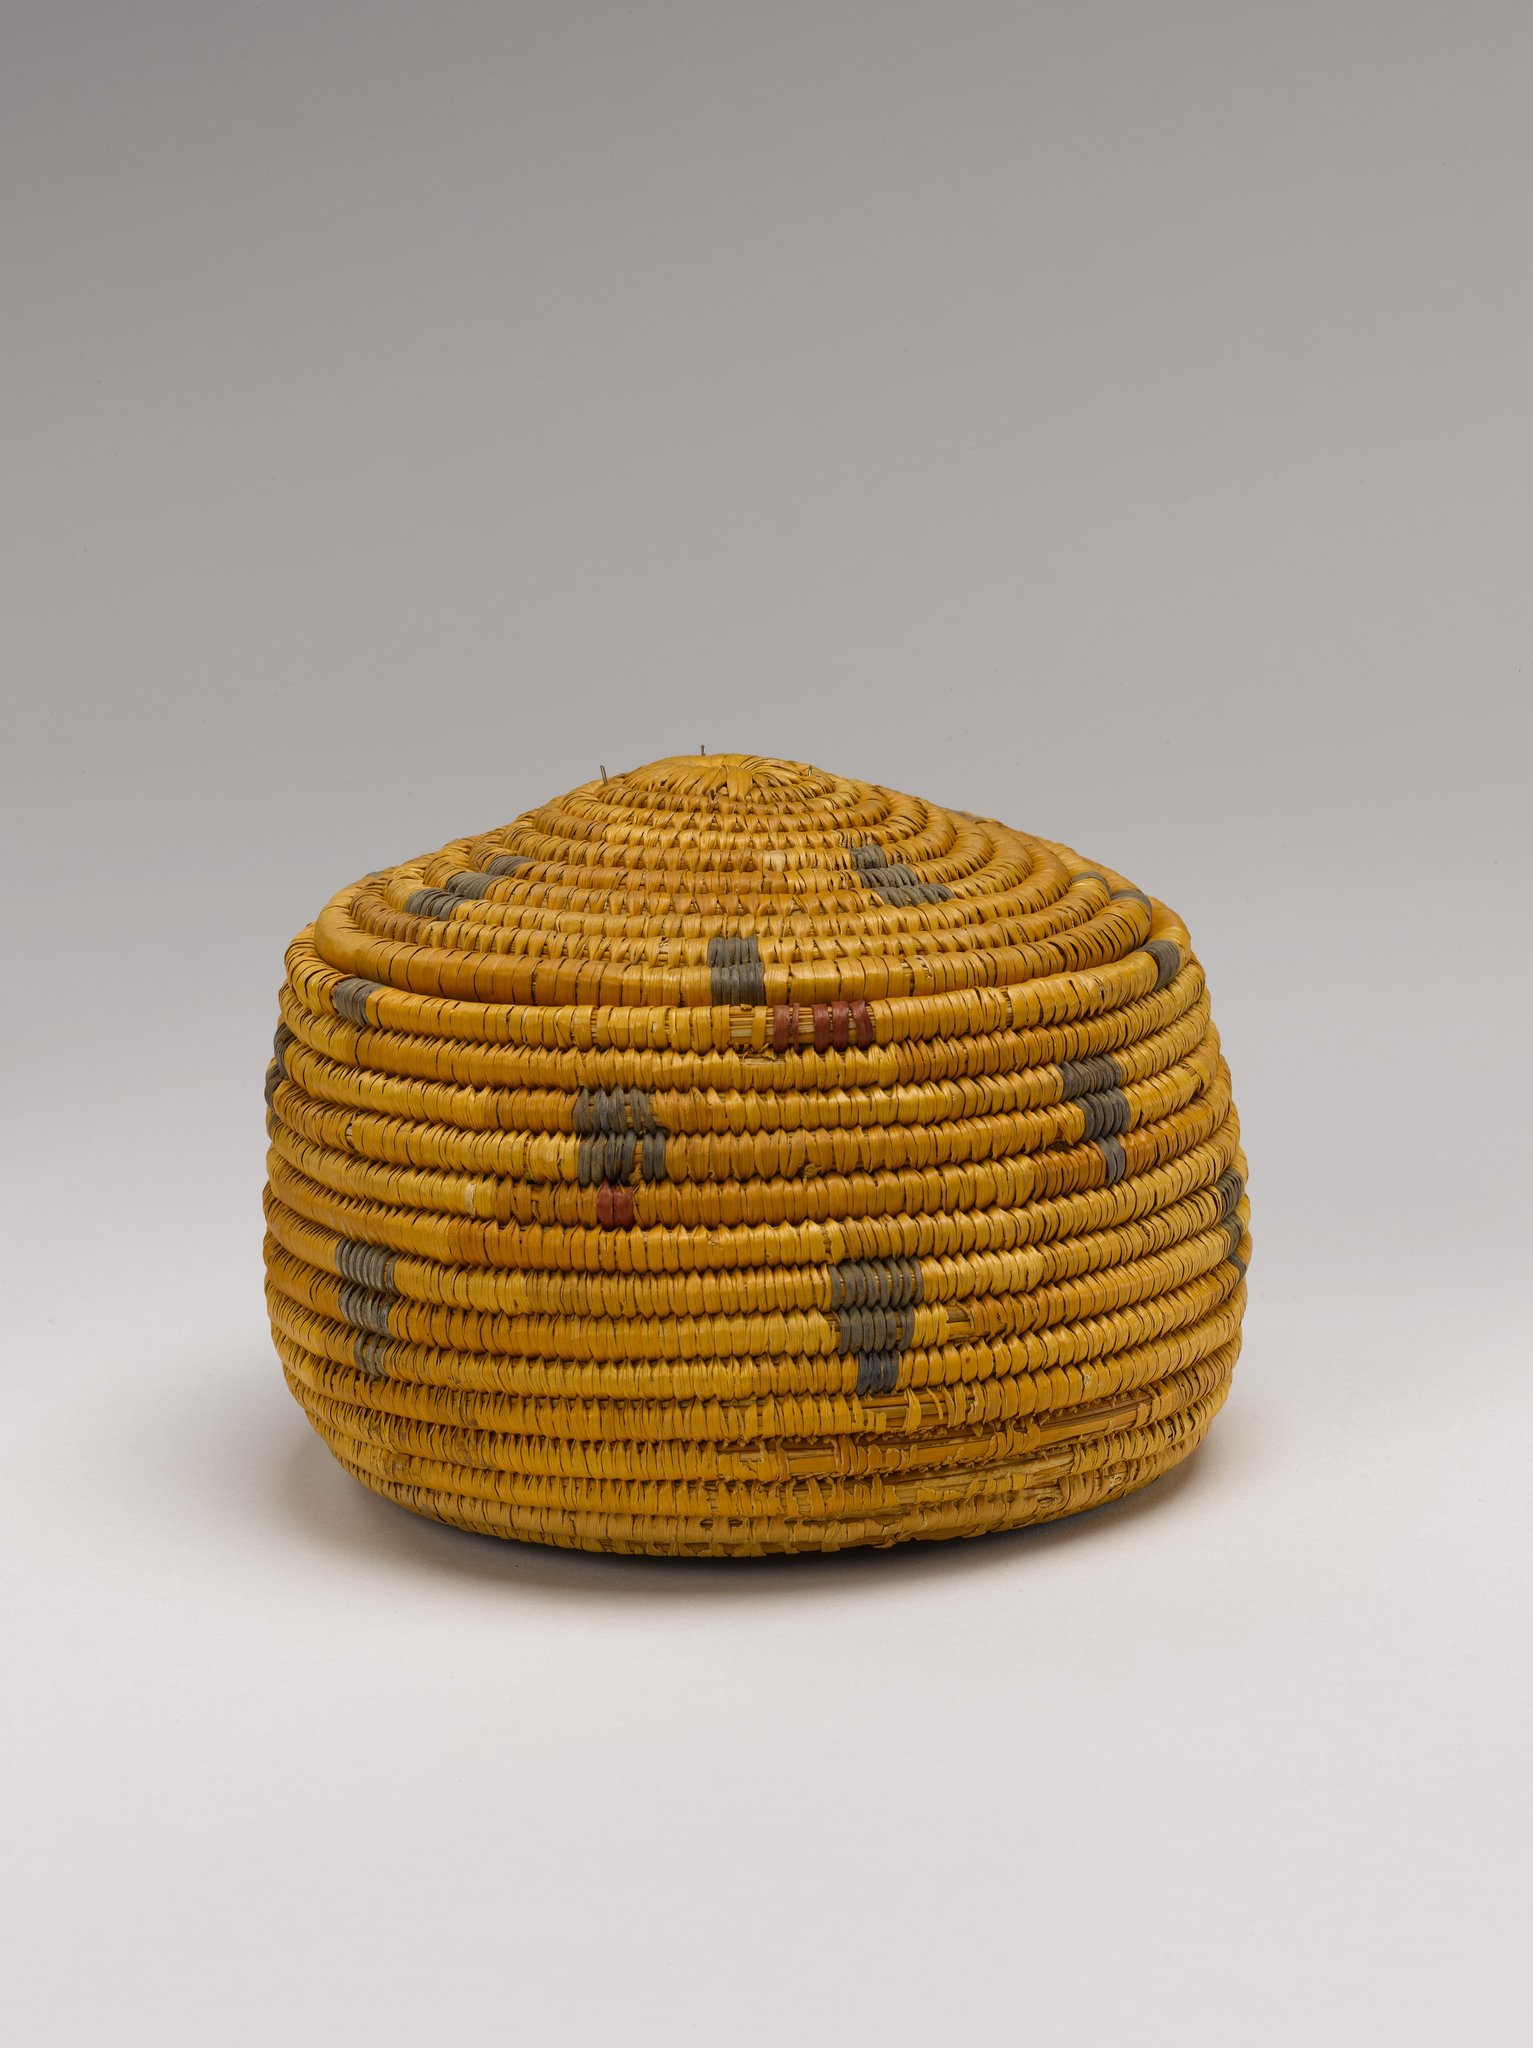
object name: basket, merytamun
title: Circular Basket with Lid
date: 1525-1504 BCE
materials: leaf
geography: egypt